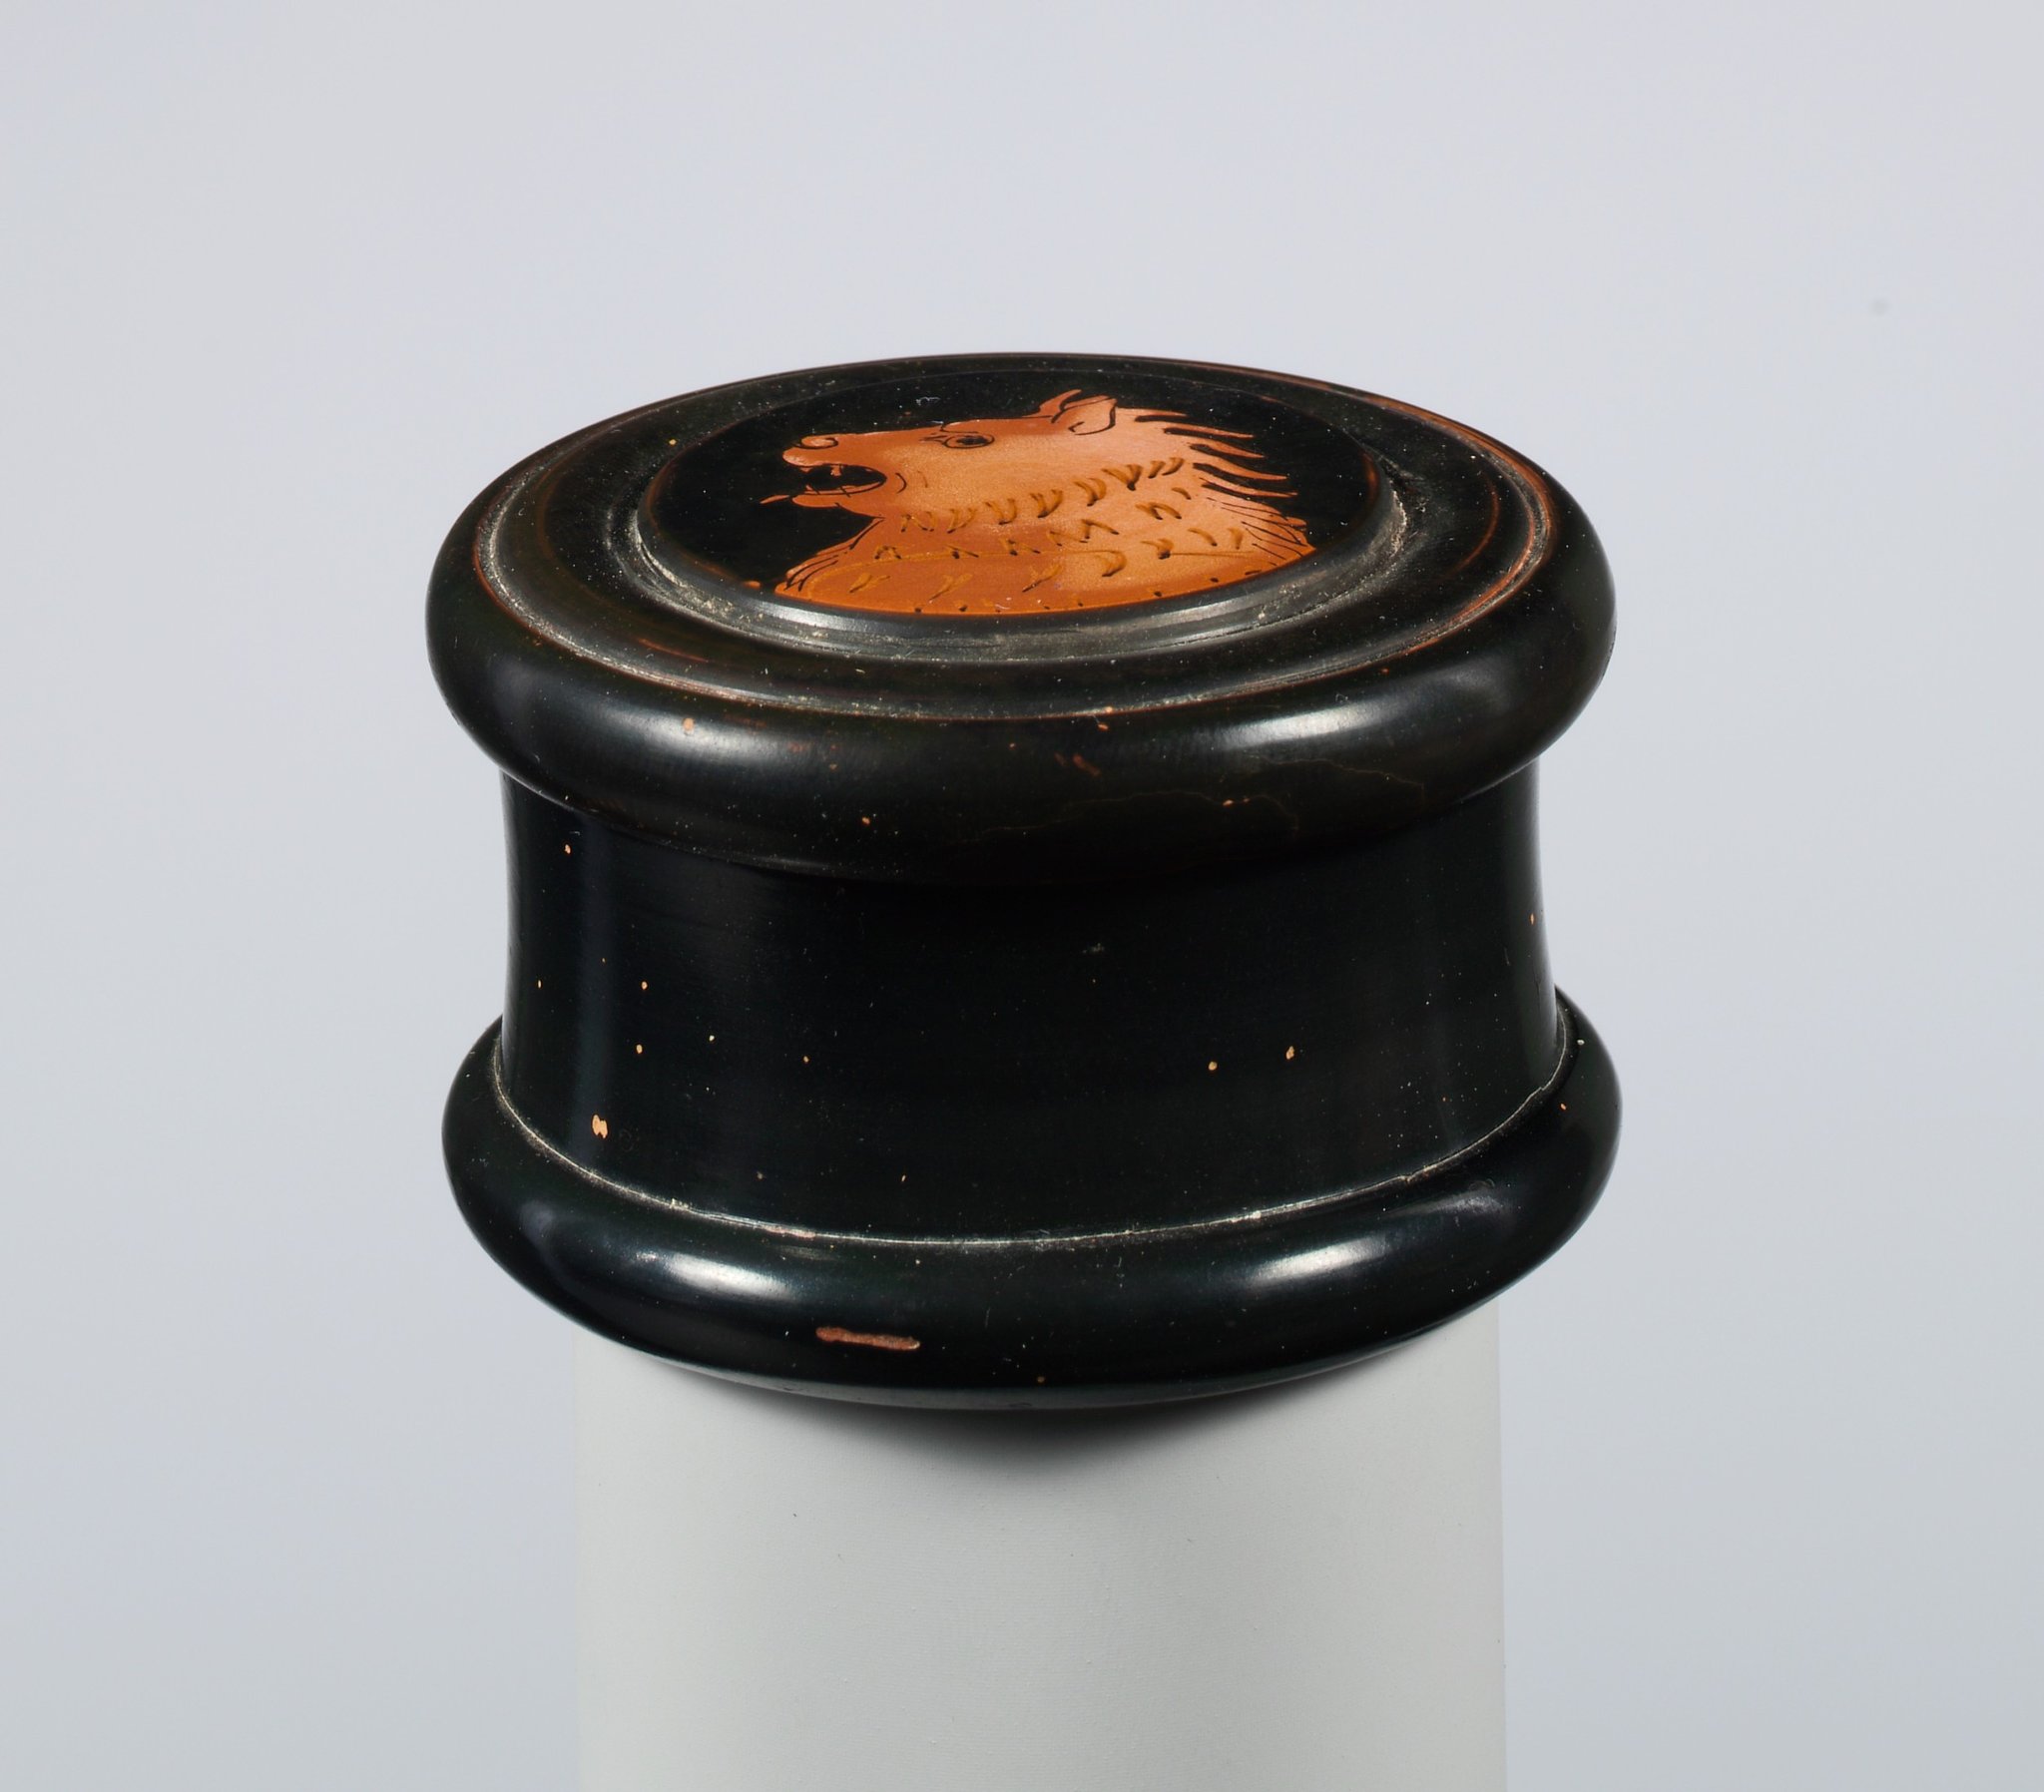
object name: pyxis with lid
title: Terracotta pyxis (box)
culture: greek, attic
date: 425-401 BCE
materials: terracotta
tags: lions